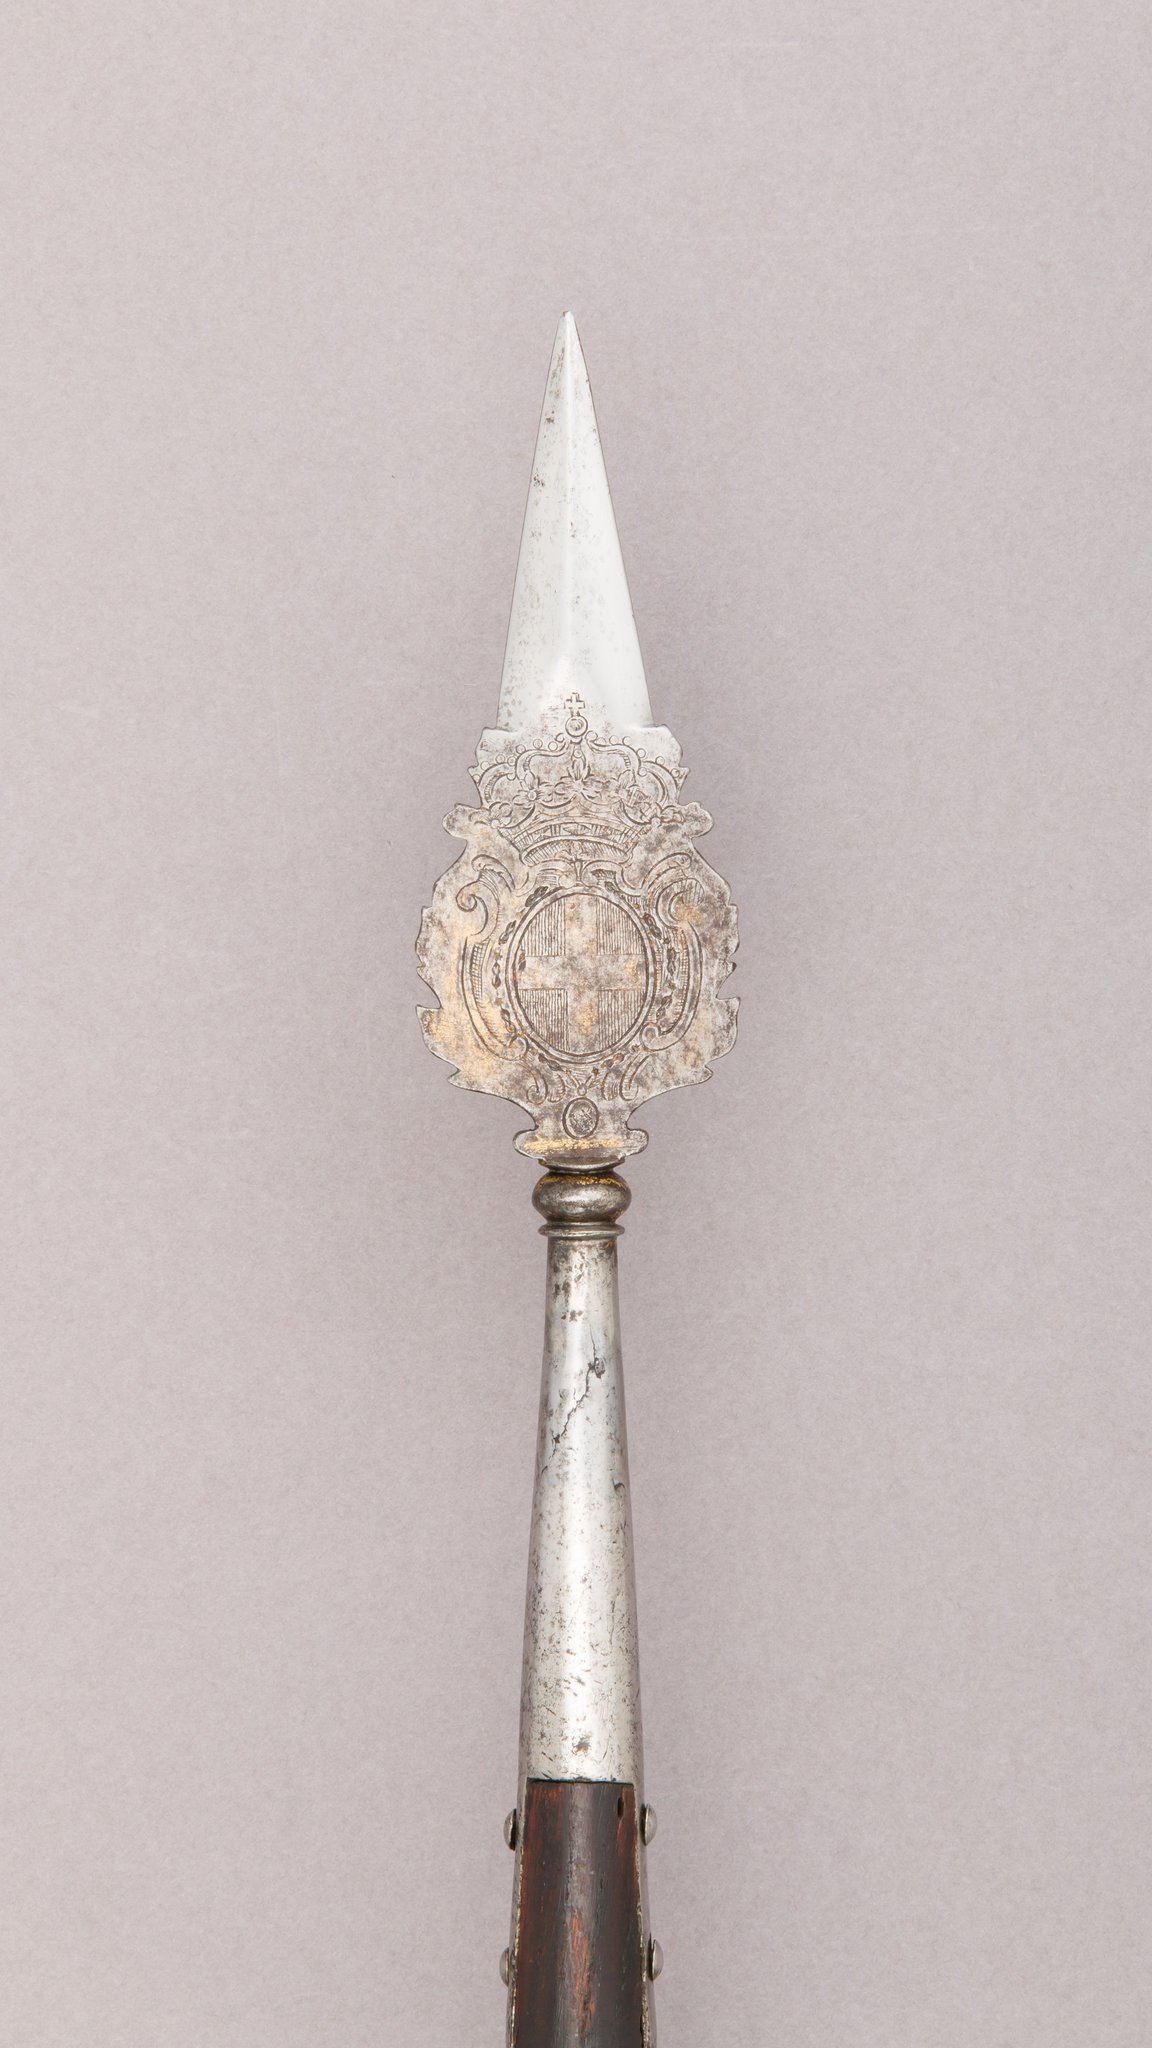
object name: spontoon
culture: italian, savoy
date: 1601-1700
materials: gold, steel, wood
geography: italy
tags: coat of arms